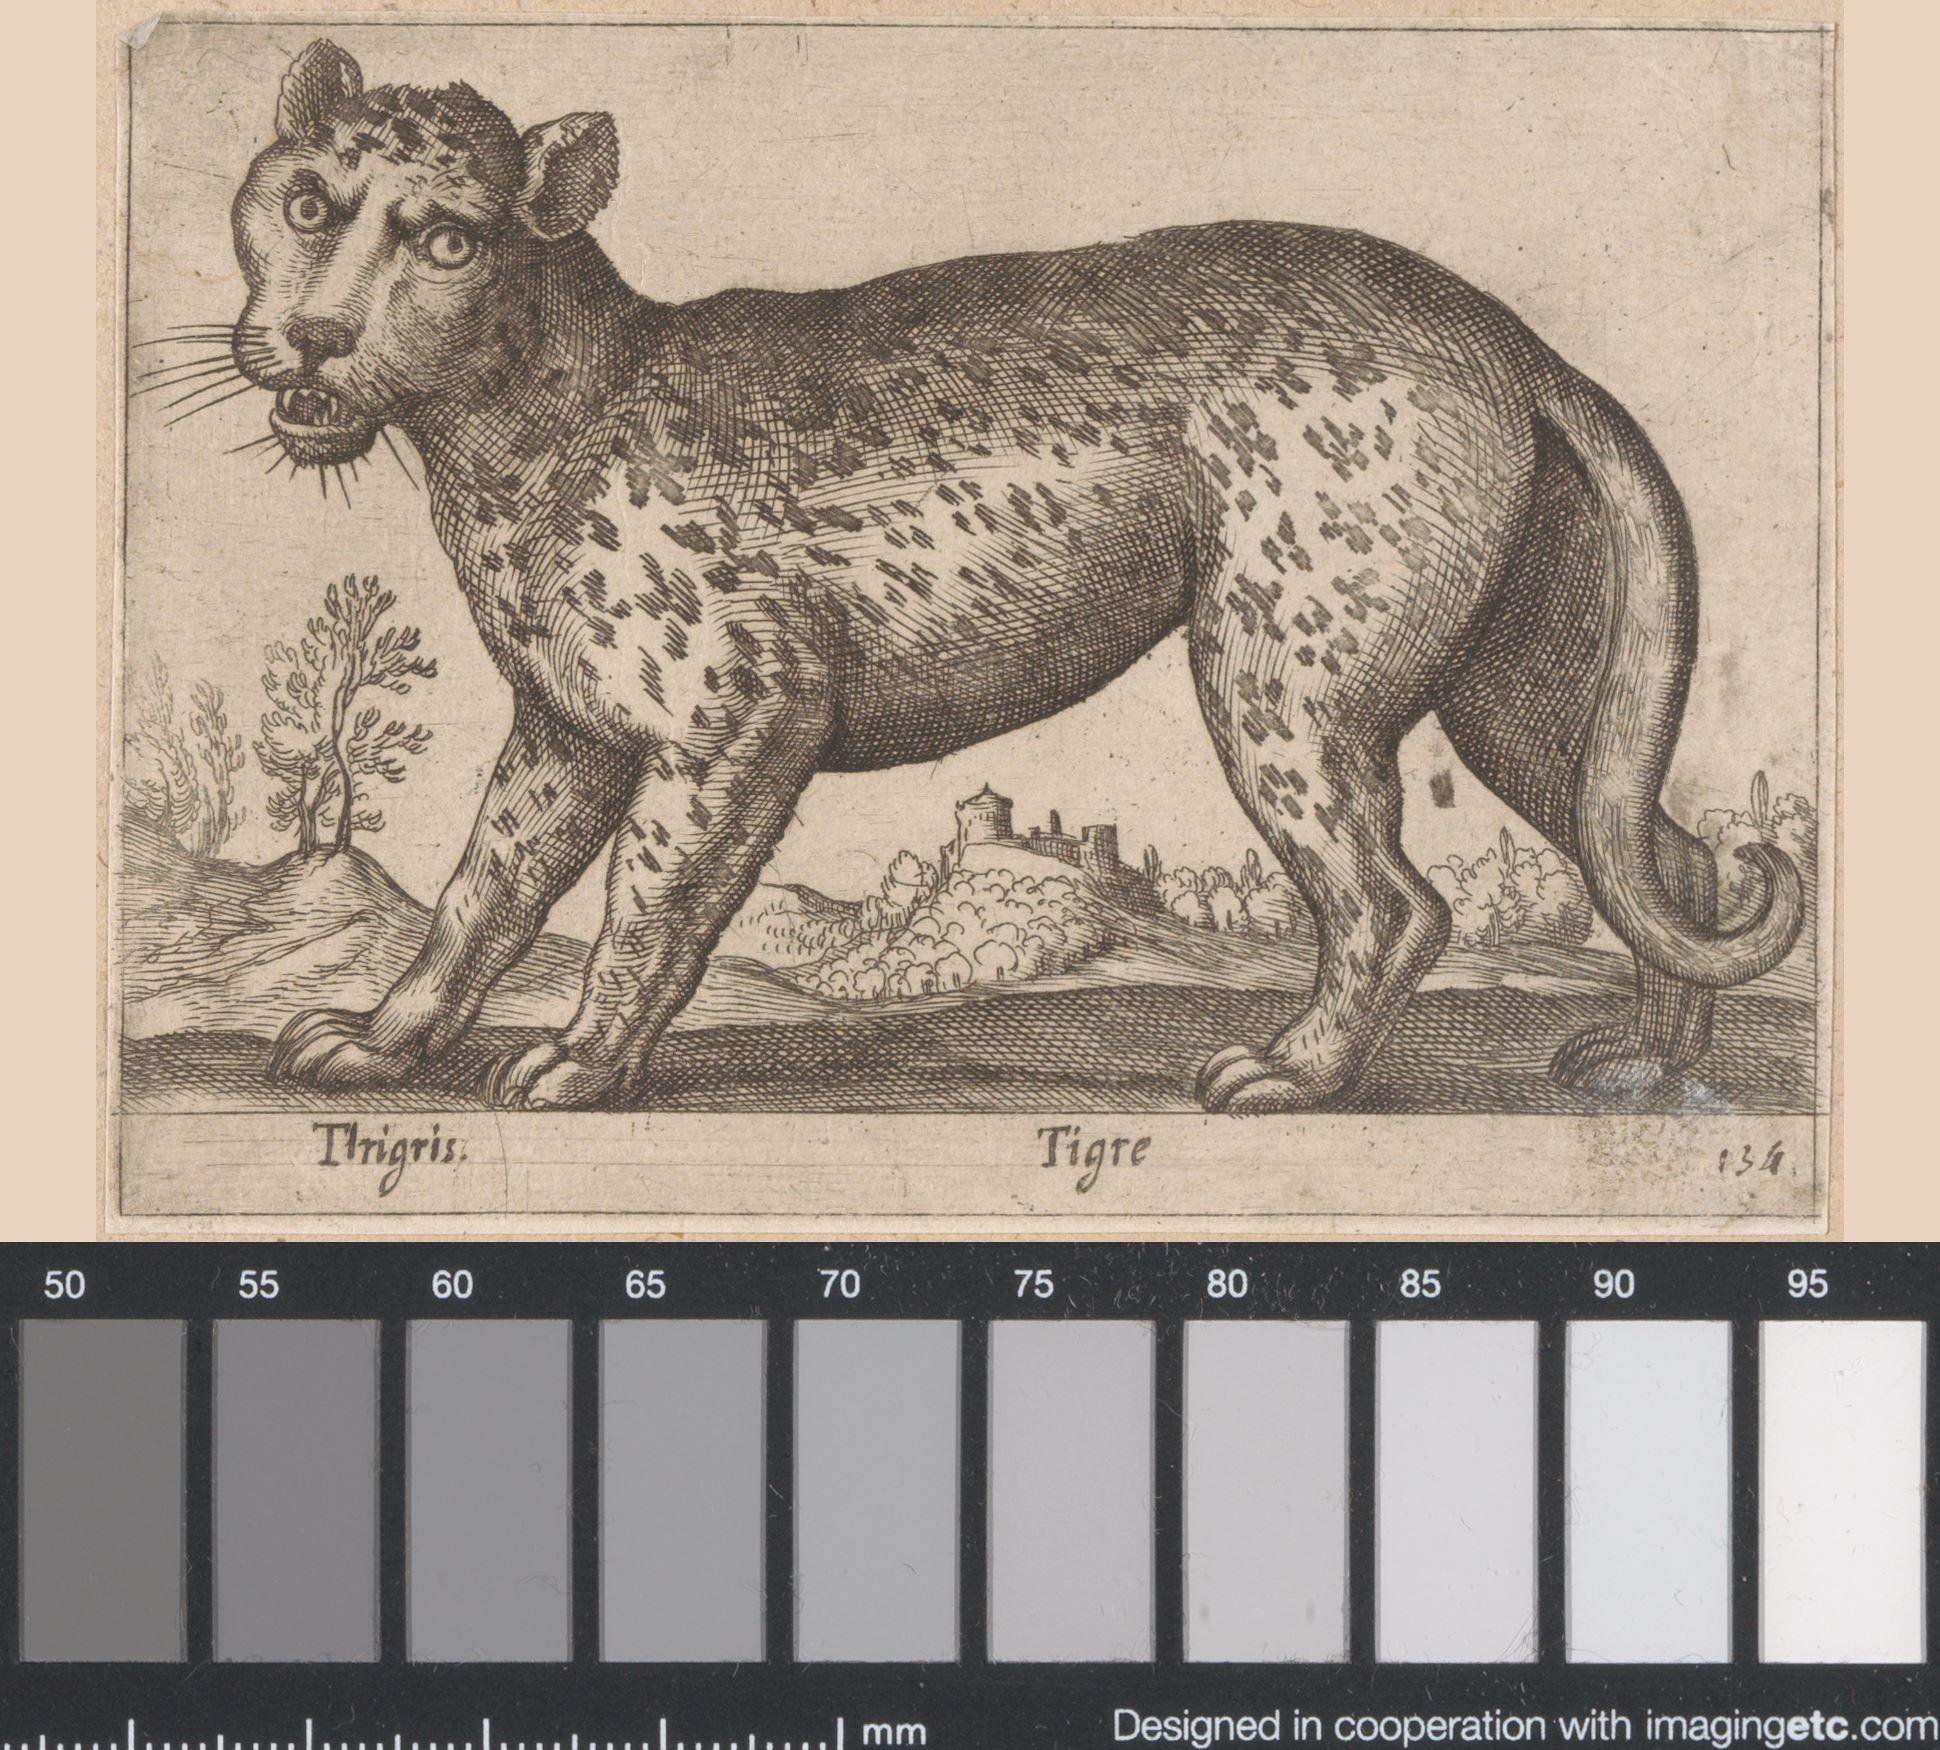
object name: print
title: Tijger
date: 1565-1630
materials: paper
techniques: etching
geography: rome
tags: beasts of prey, predatory animals: tiger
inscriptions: number: ‘134’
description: Deze prent maakt deel uit van een reeks prenten van dieren door Antonio Tempesta. Bekend is dat een tweede staat (met nummering) van deze serie is uitgegeven door Giovanni Giacomo de' Rossi in 1650. Onbekend is wie de eerste staat heeft uitgegeven en wanneer.